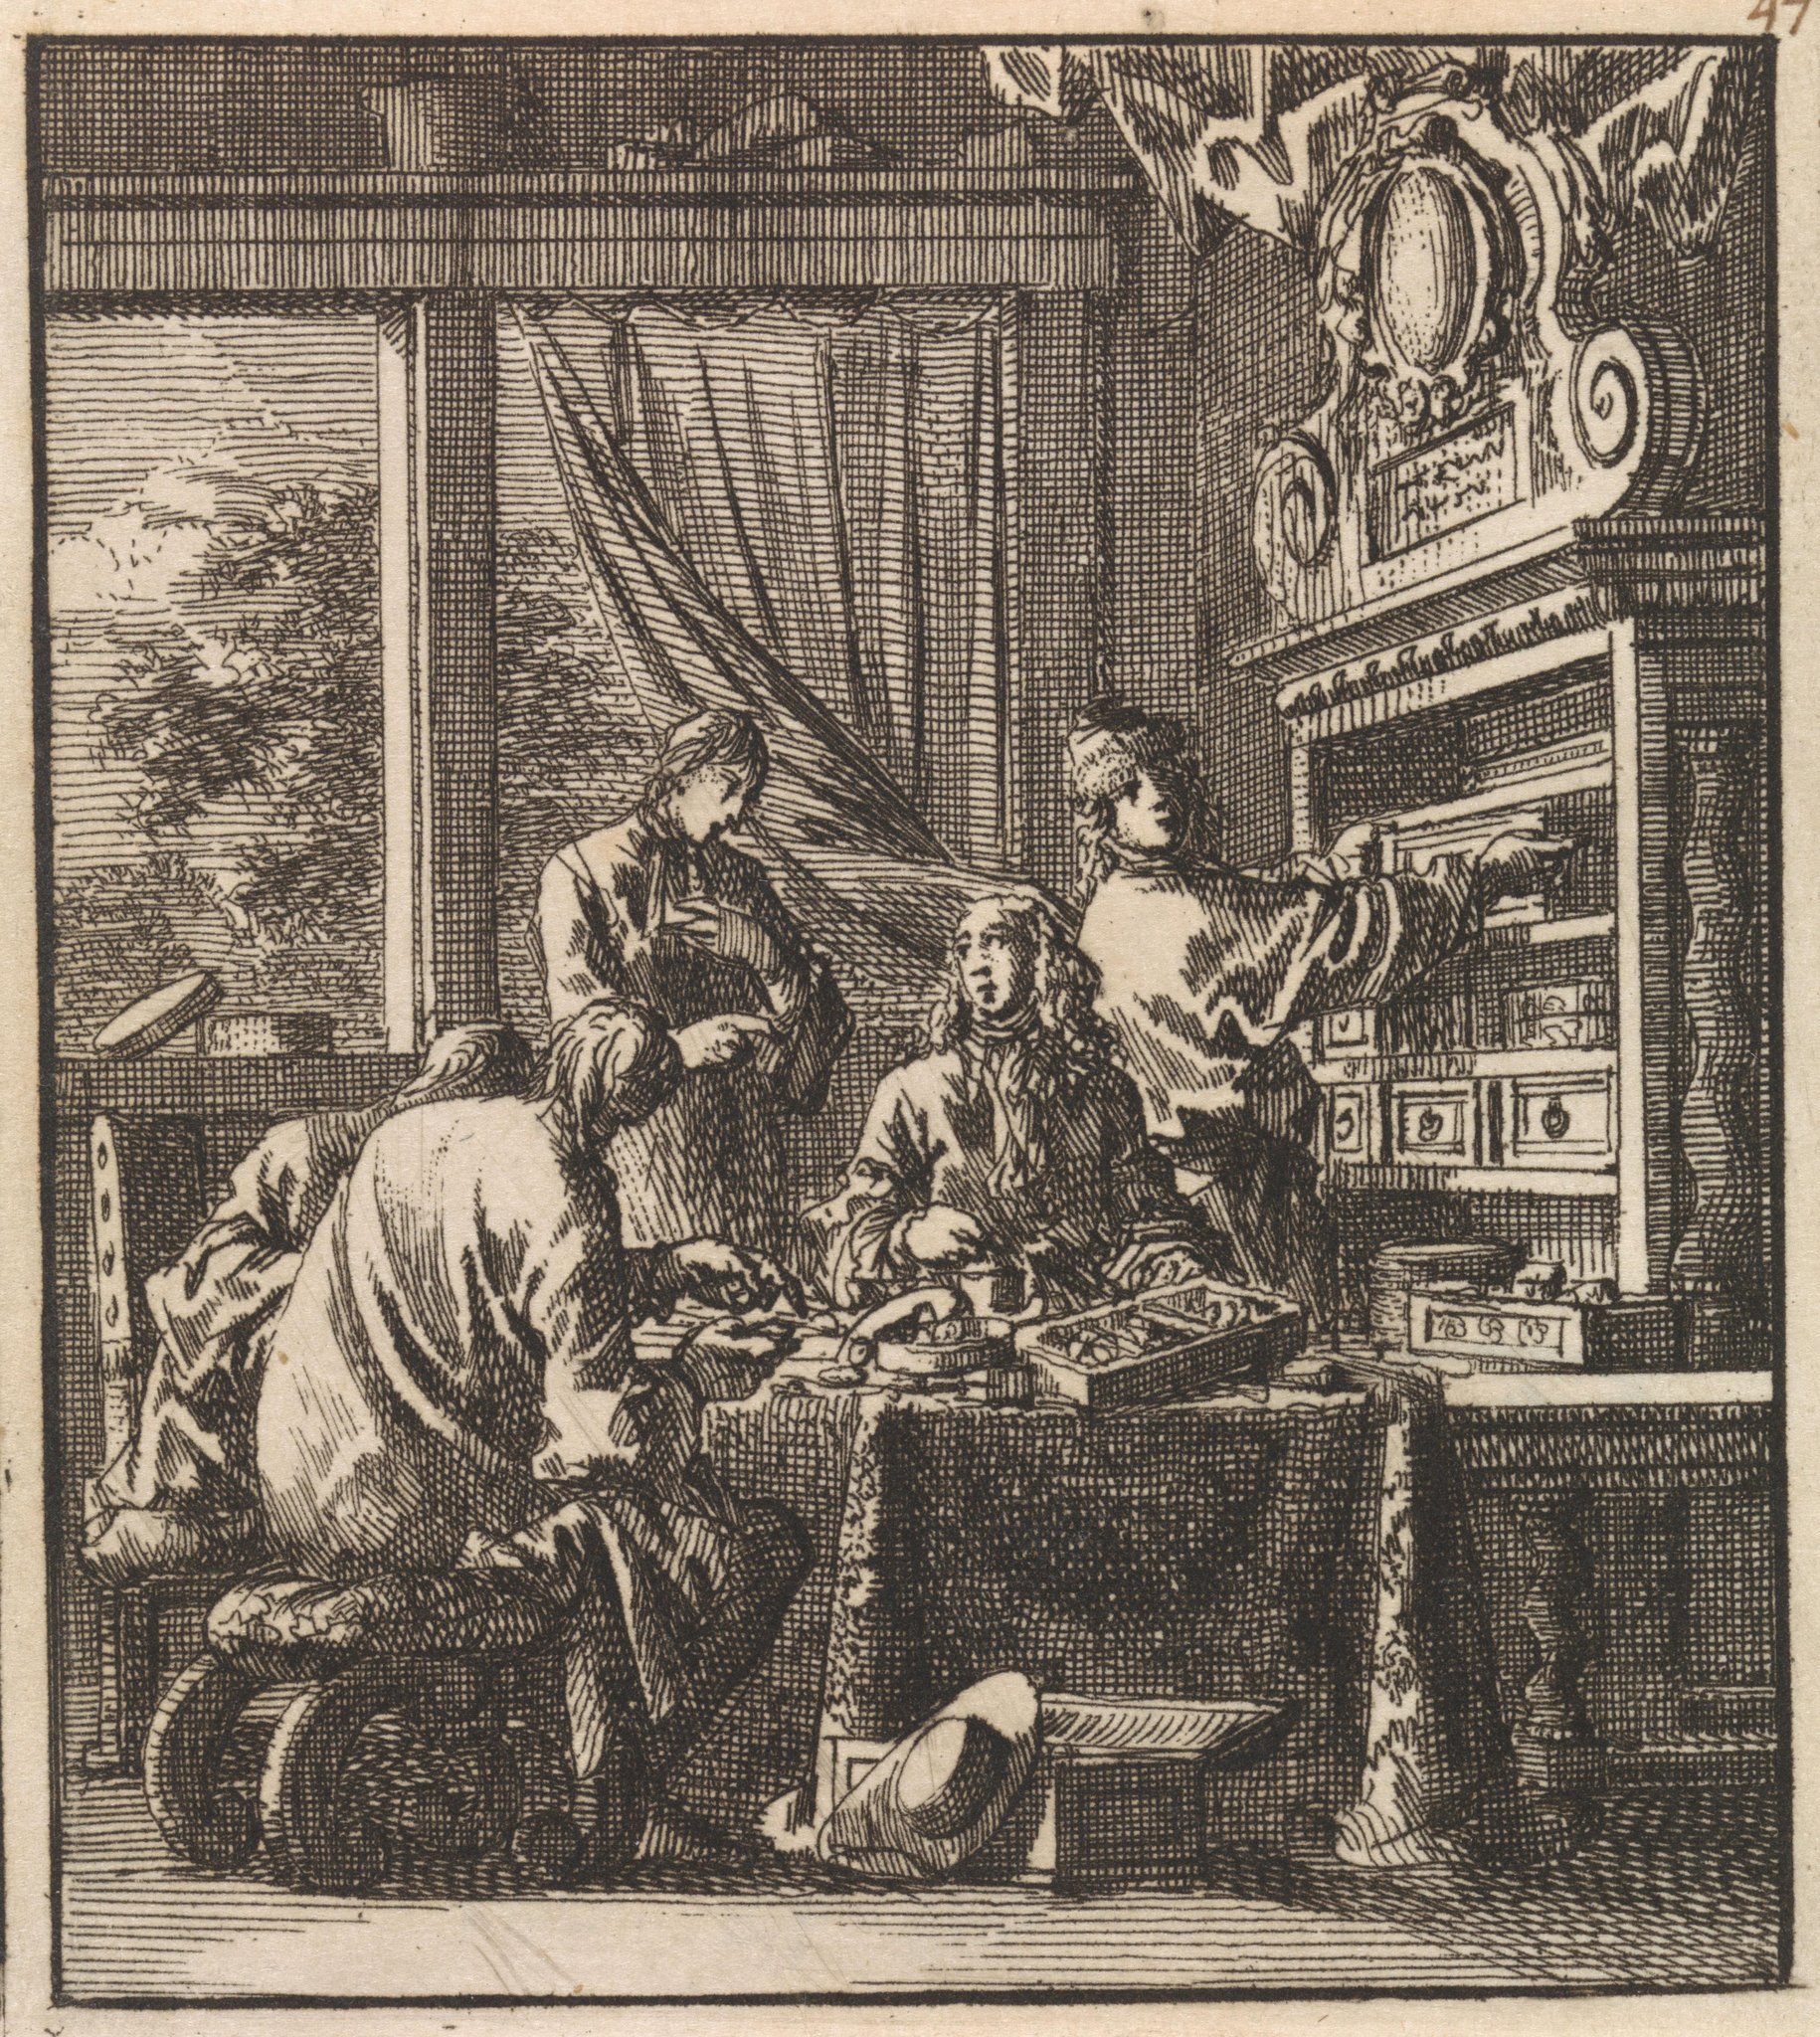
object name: print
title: Vijf mannen bekijken de inhoud van diverse laden uit een kabinet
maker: jan luyken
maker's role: draughtsman, print maker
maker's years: 1649-1712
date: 1711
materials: paper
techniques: etching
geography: amsterdam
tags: 'kunstschrank'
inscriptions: collector's mark: Lugt 2228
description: Proefdruk van illustratie voor: Luyken, Jan. Het leerzaam huisraad, vertoond in vyftig konstige figuuren, met godlyke spreuken en stichtelyke verzen: Pieter Arentsz. II (wed.) en Cornelis van der Sys, 1711, p. 164.